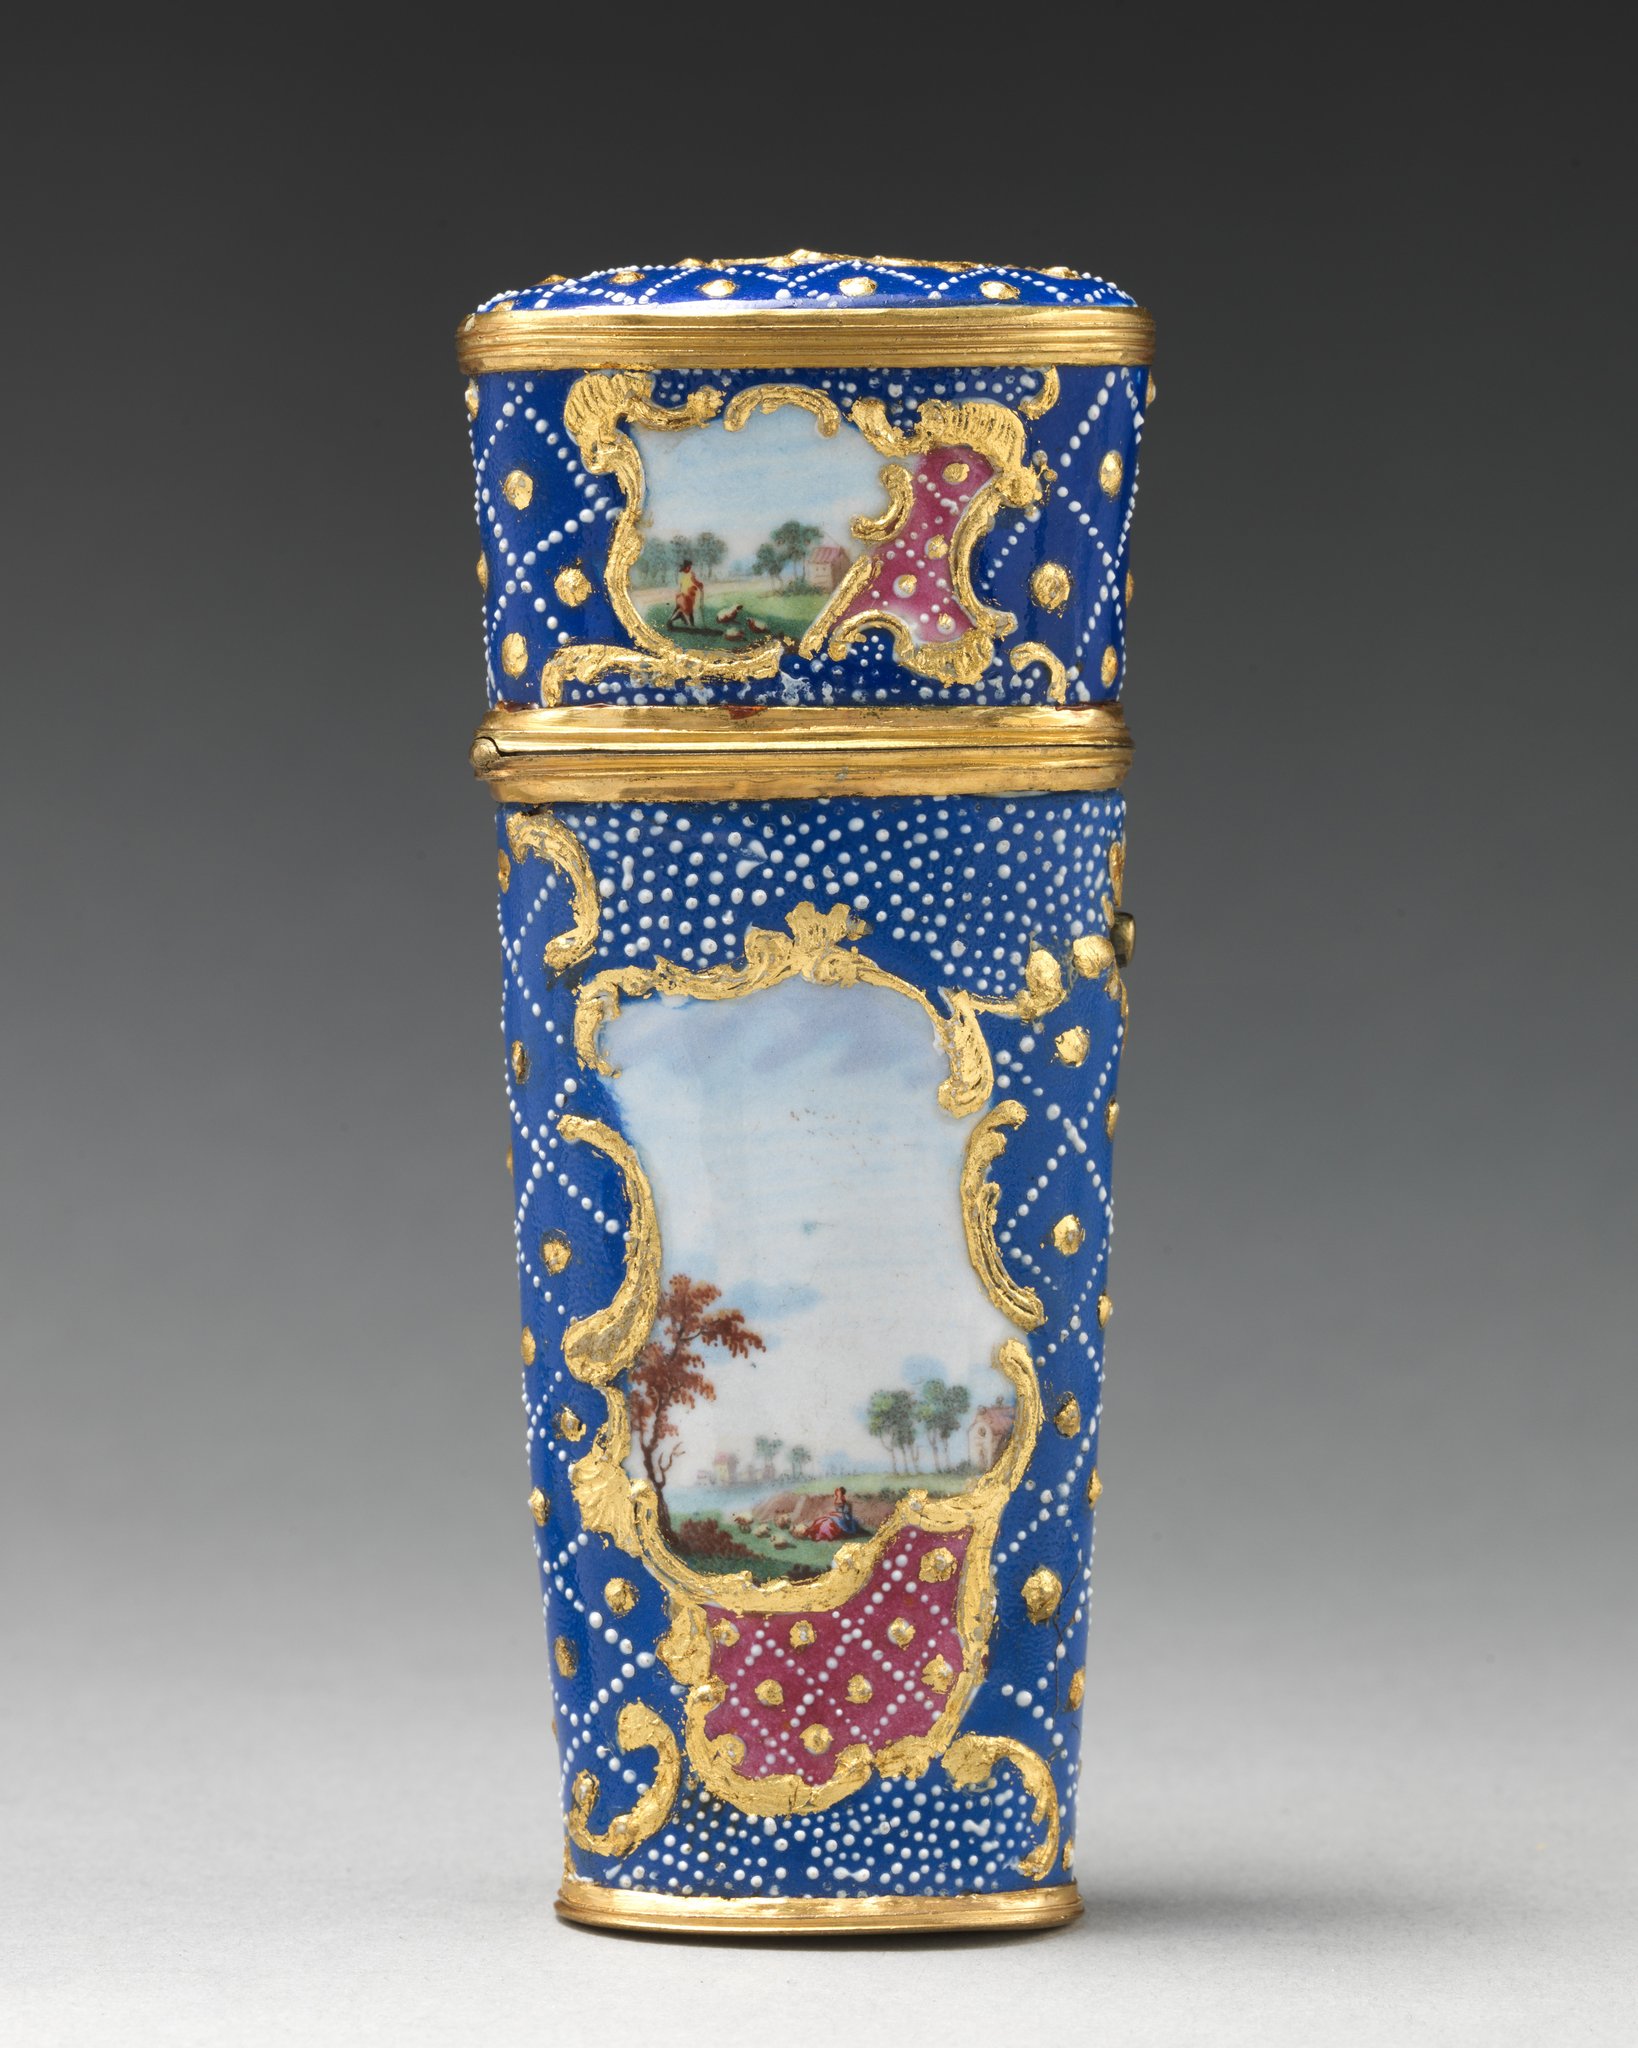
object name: étui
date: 1765-1770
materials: copper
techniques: enamel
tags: animals,houses,men,trees